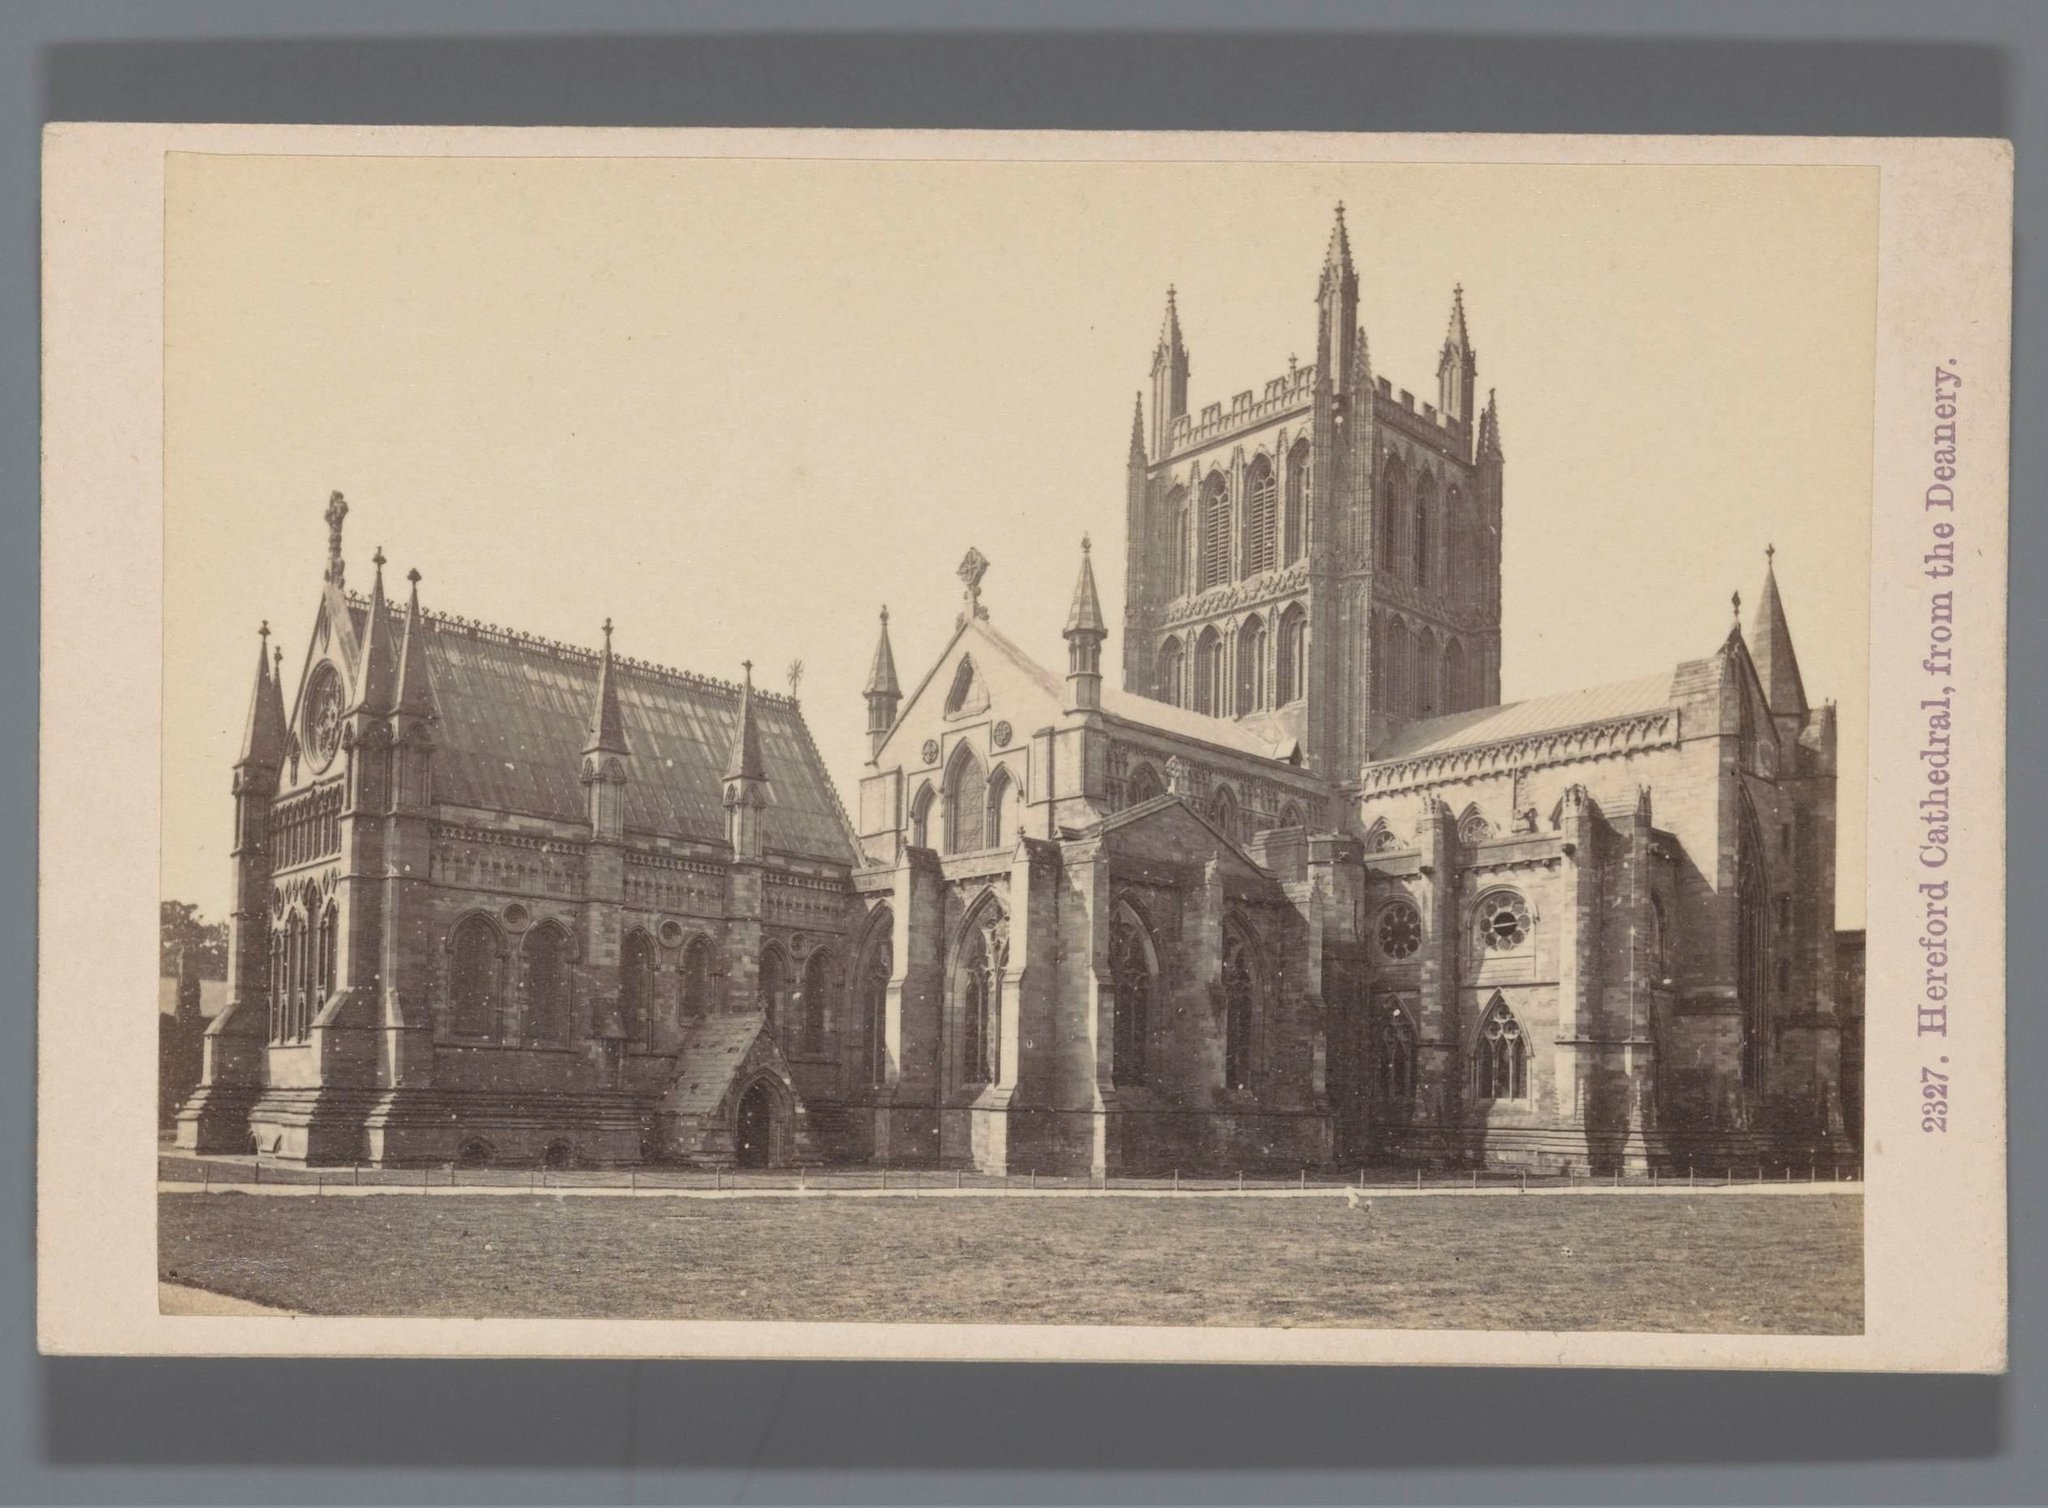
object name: carte de visite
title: Hereford Cathedral, from the Deanery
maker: francis bedford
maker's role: print maker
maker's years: 1815-1894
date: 1856-1894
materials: cardboard, paper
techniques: albumen print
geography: hereford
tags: church (exterior)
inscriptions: inscription: ‘PHOTOGRAPHED BY/ F. BEDFORD/ PHOTOGRAPHER TO/ H.R.H./ THE PRINCE OF WALES.’, number: ‘2327.’